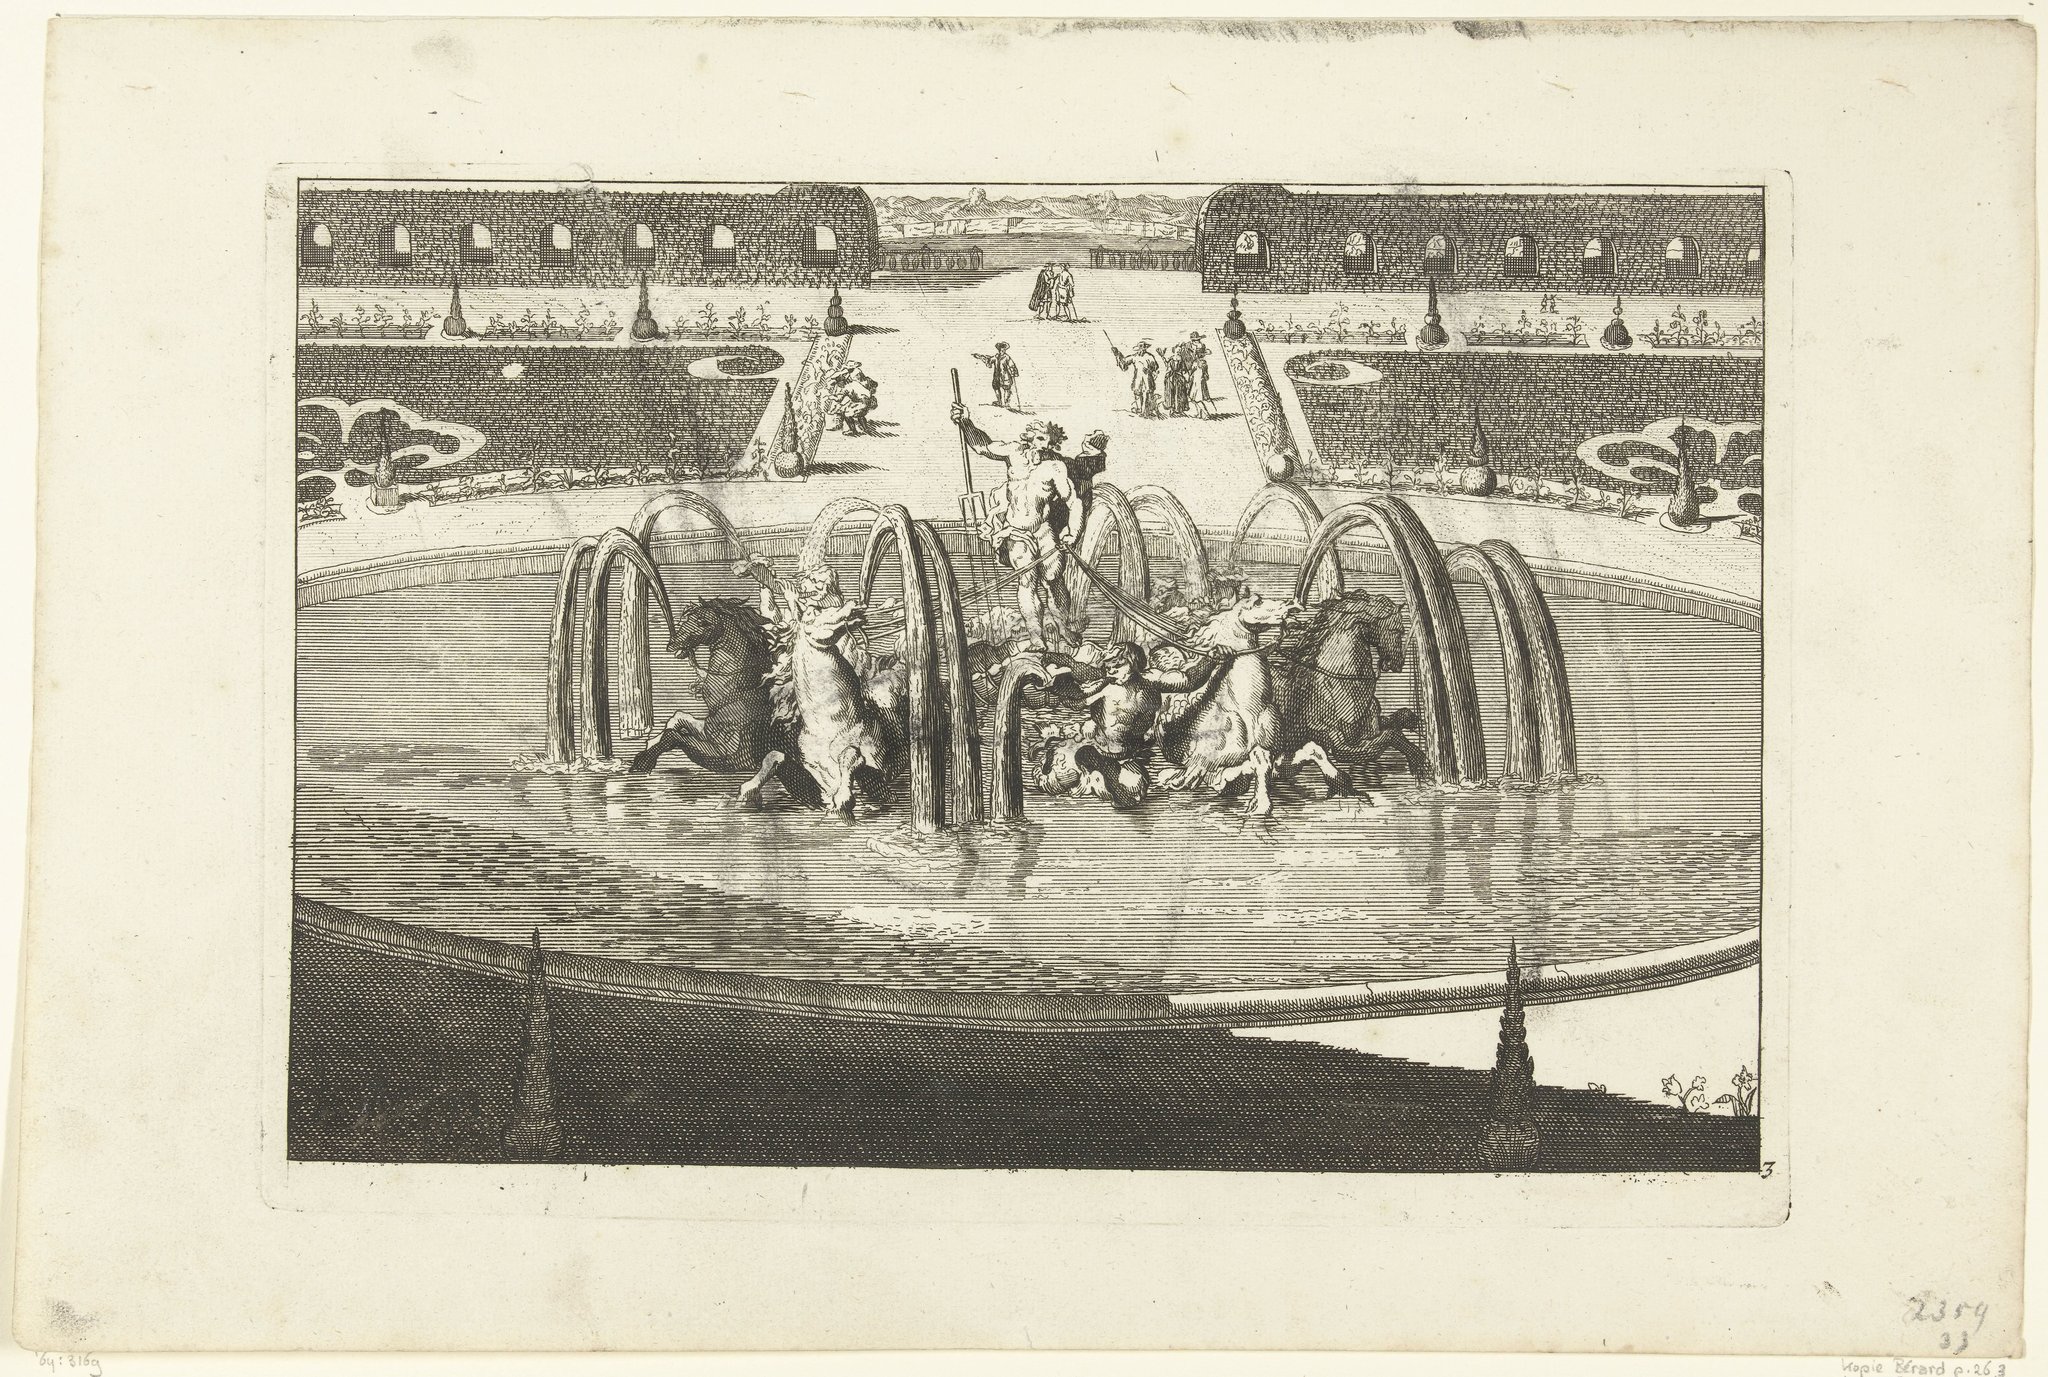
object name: ornament print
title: Fontein met Neptunus op zijn strijdwagen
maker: Anonymous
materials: paper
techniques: etching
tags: garden fountain, triumph of neptune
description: De wagen wordt getrokken door vier zeepaarden. Kopie naar blad uit serie Liure de fontaines uitgegeven door Daniel Marot.